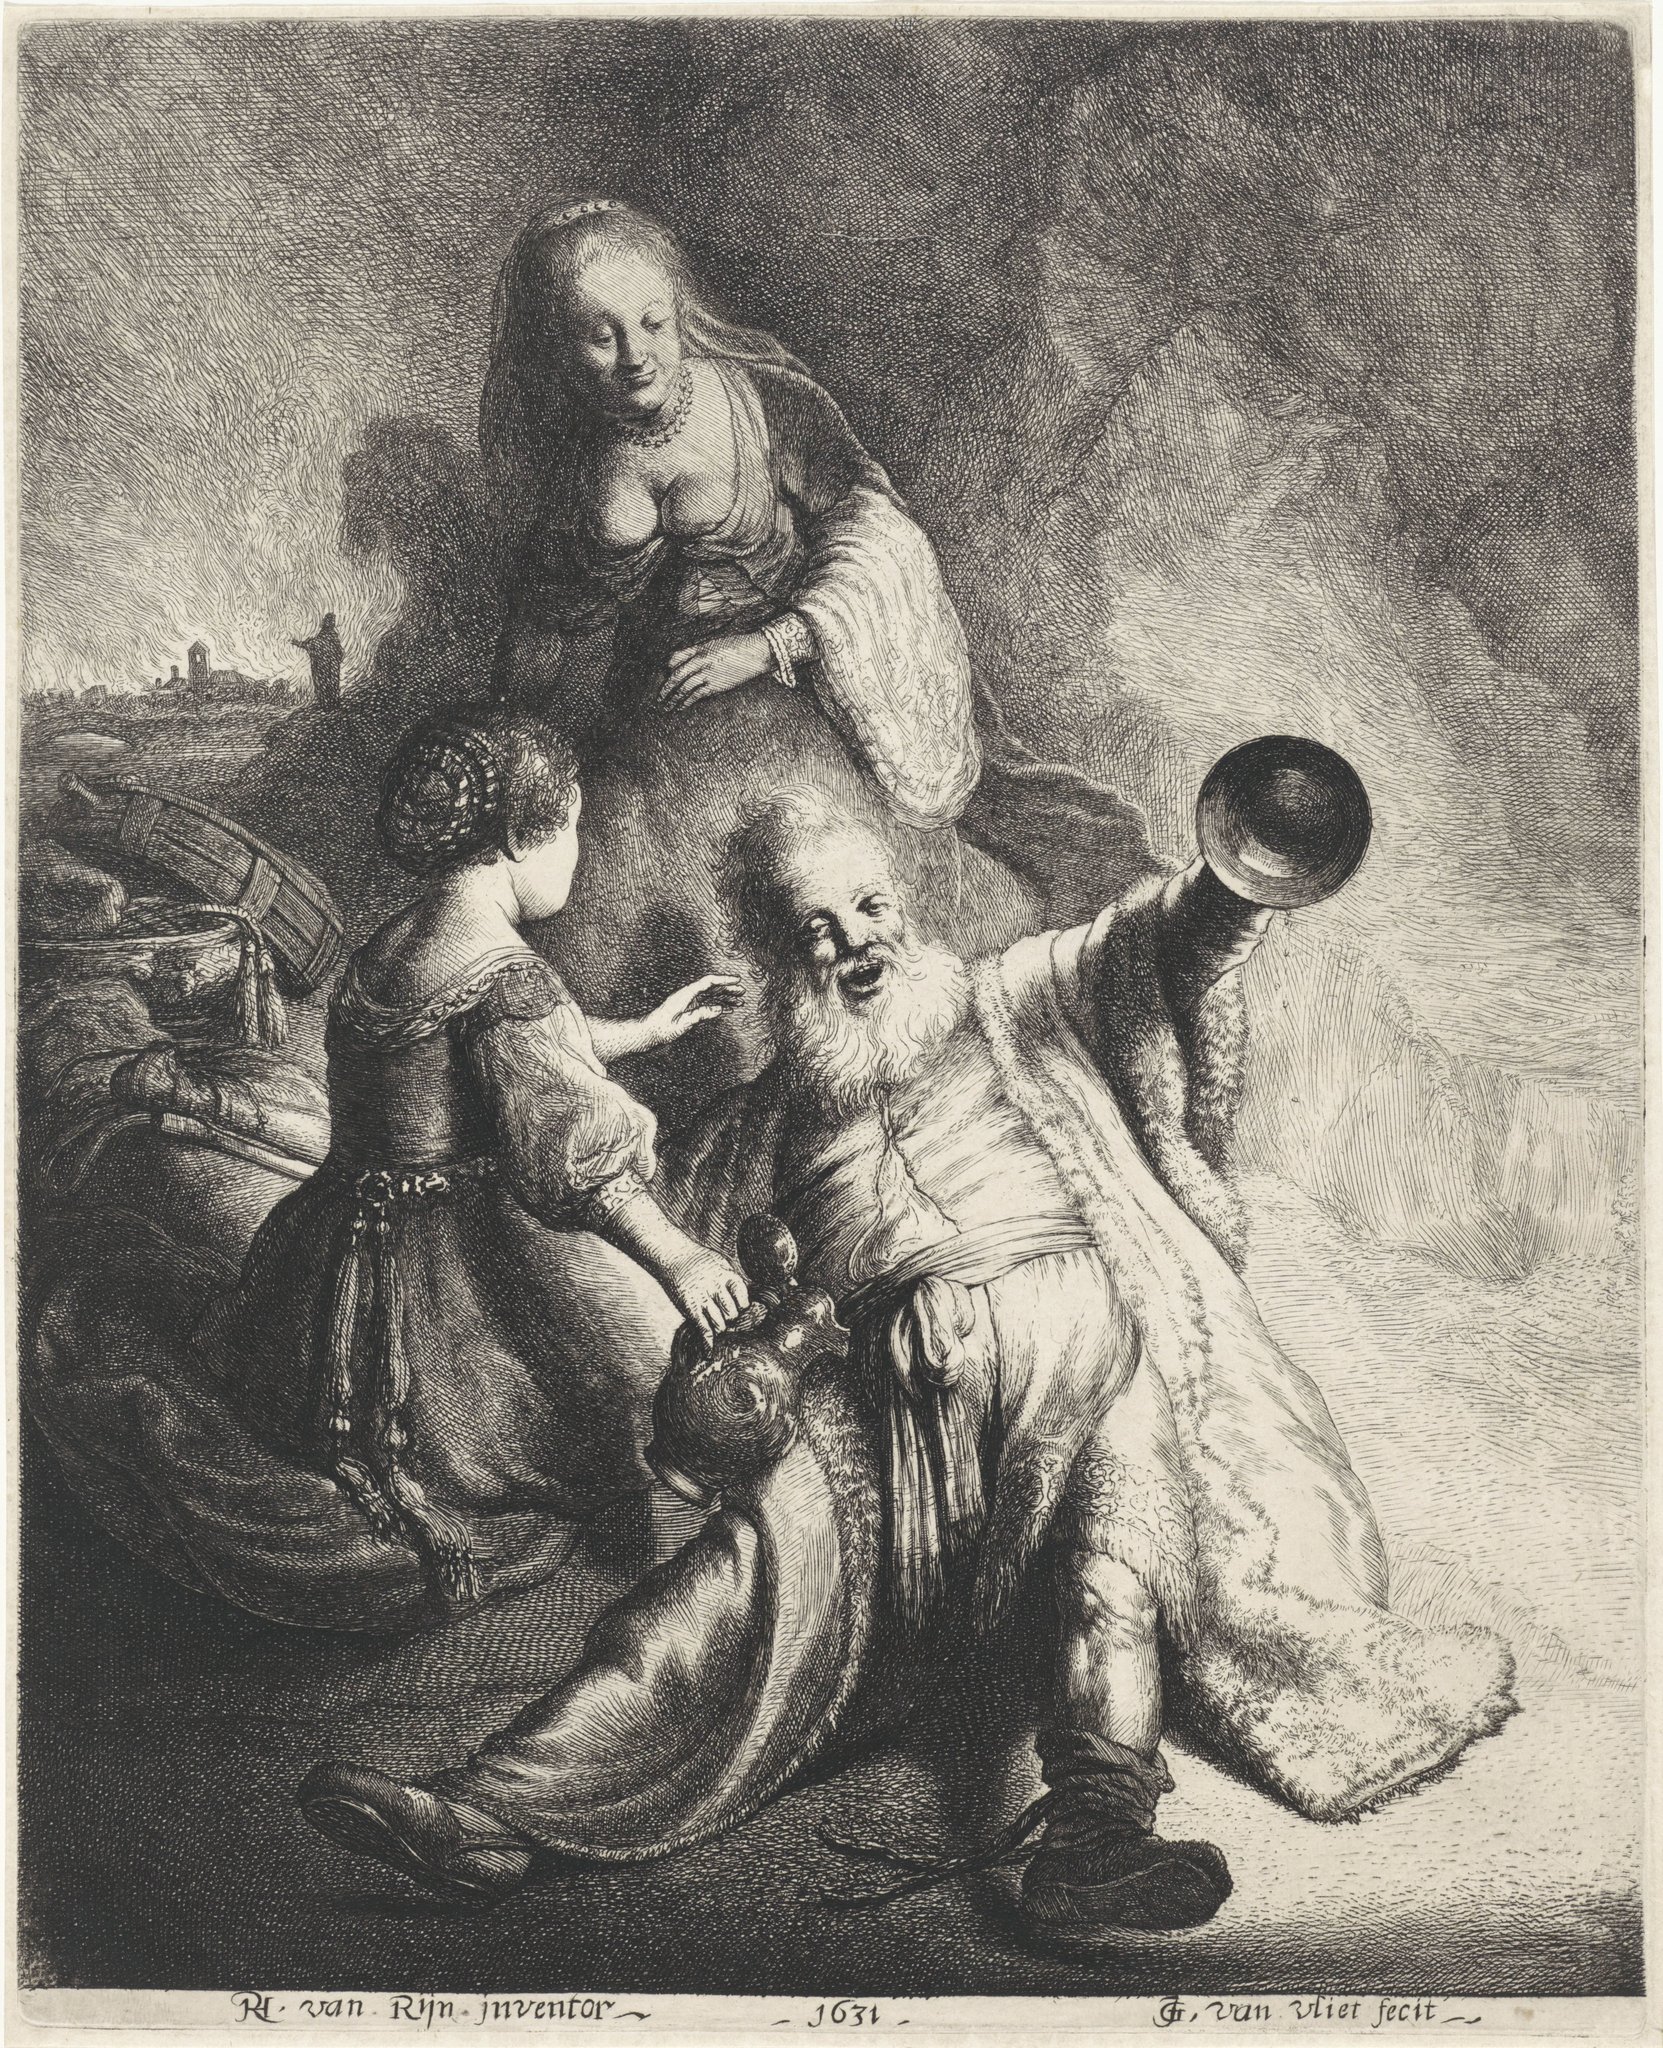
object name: print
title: Lot en zijn dochters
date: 1631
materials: paper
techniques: engraving, etching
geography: leiden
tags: lot's daughters make their father drunk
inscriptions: collector's mark: Lugt 240